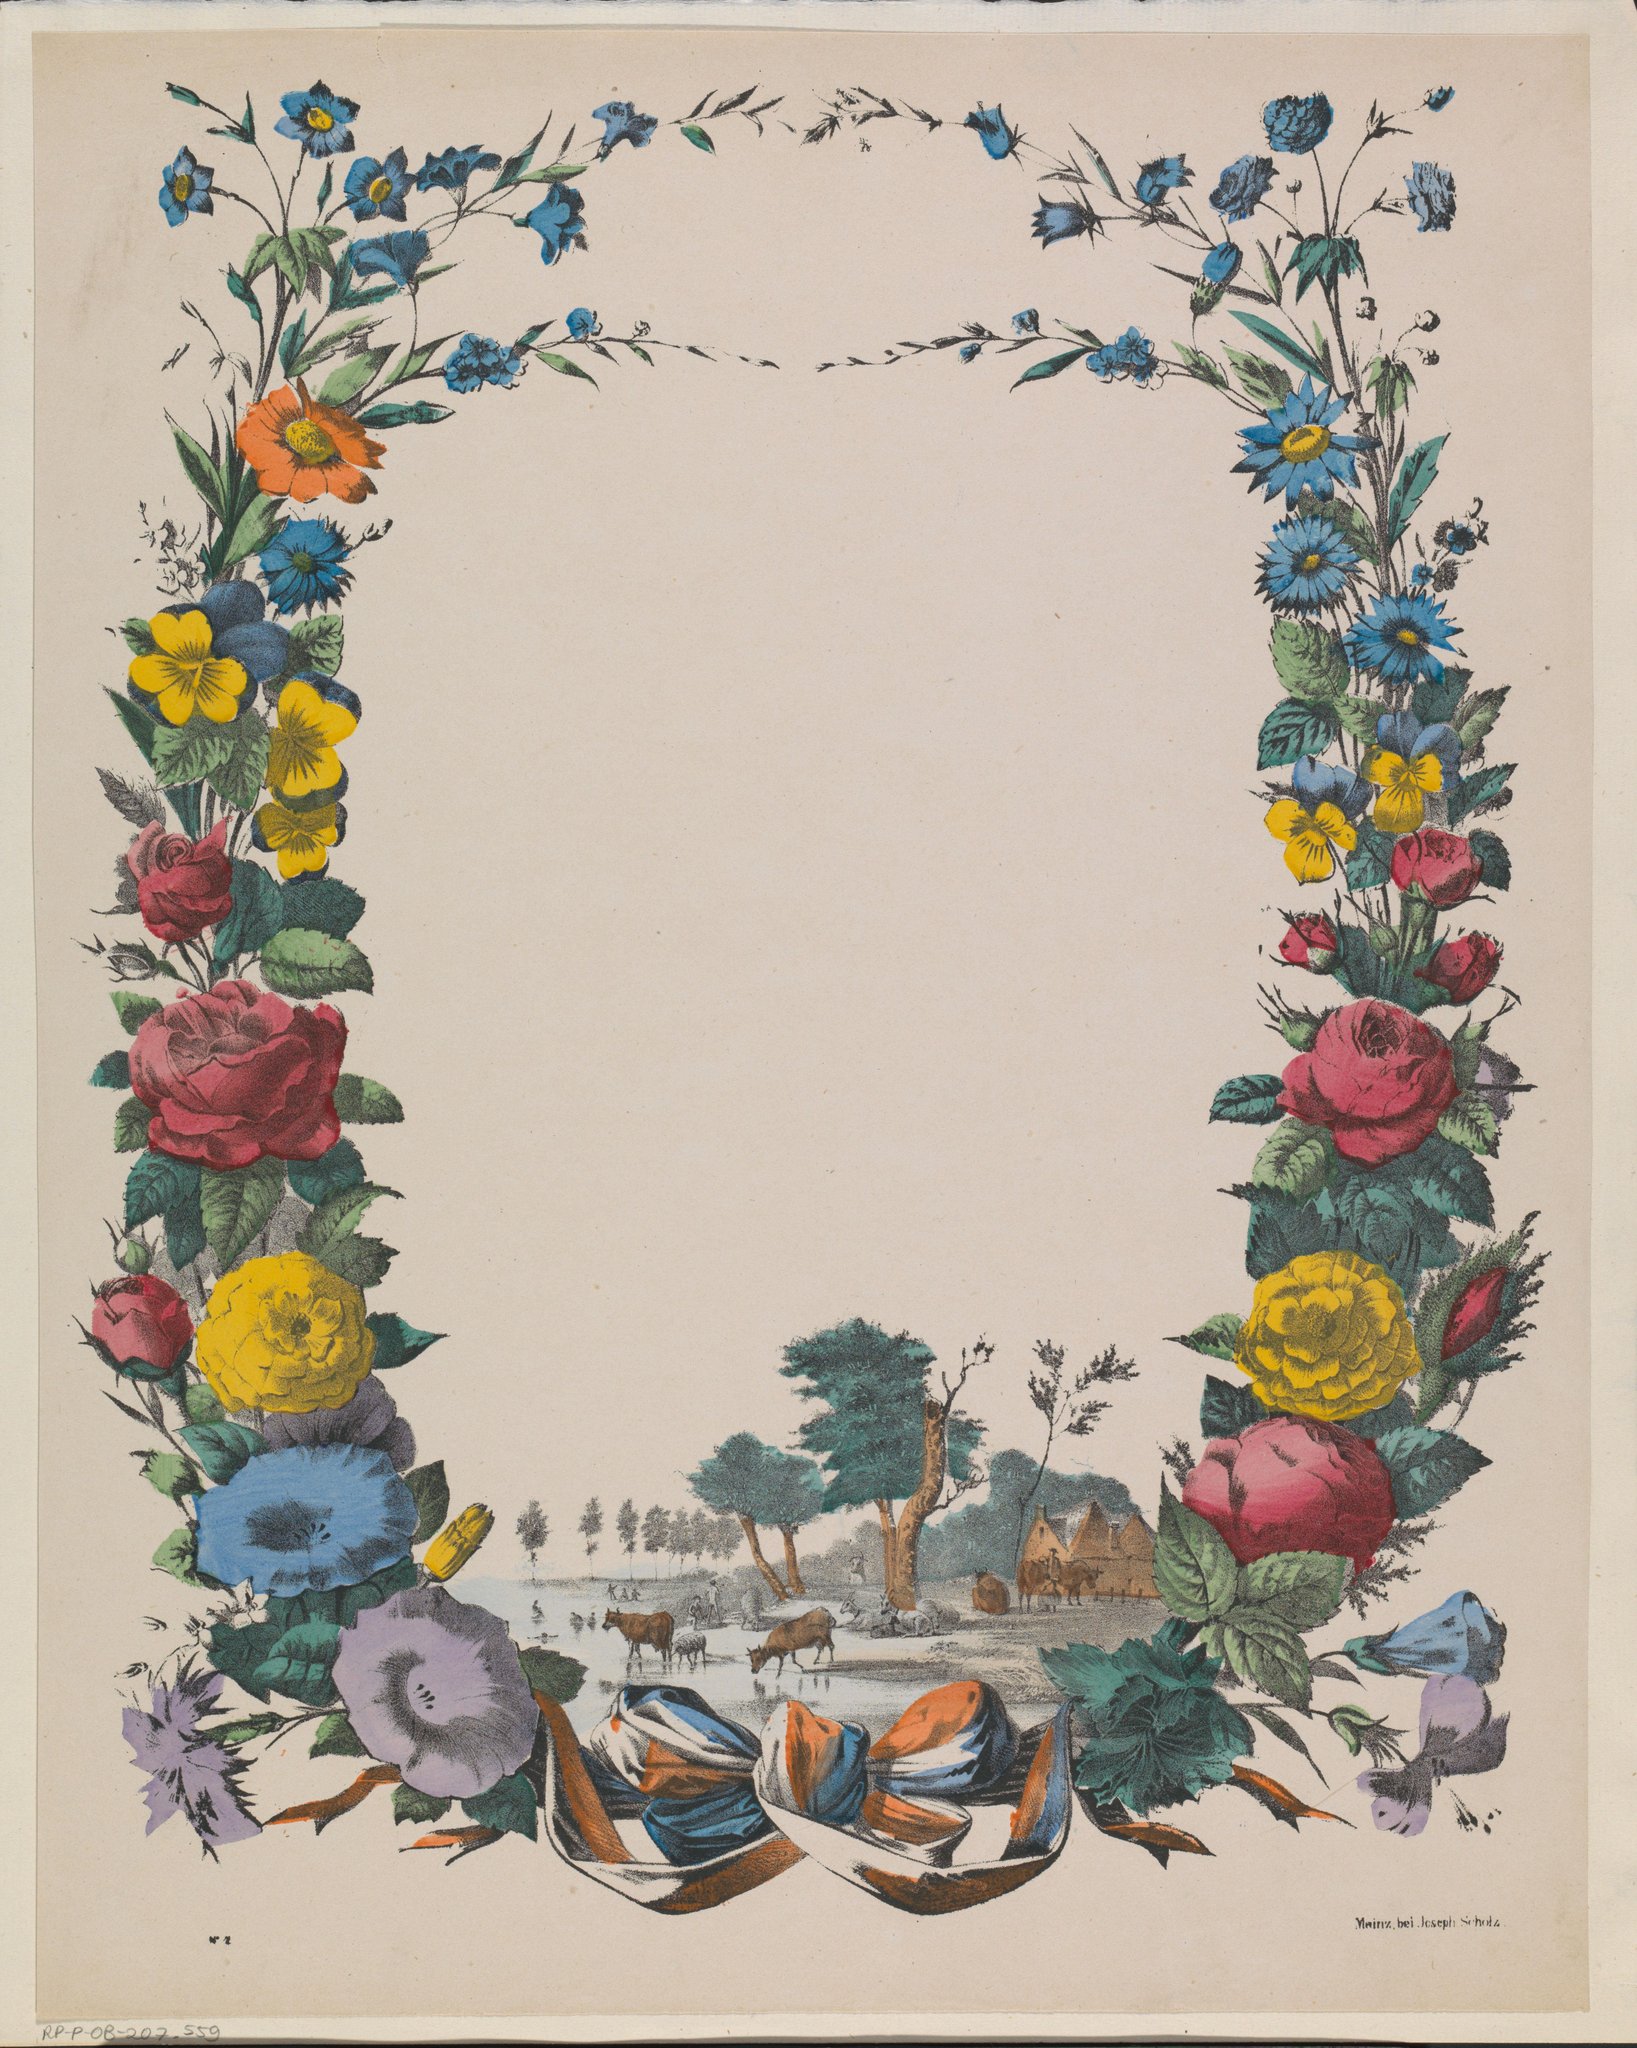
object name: popular print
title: Wensbrief met bloemenkrans en landschap met boerderij en dieren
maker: Anonymous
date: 1829-1880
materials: paper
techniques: colour, lithograph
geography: mainz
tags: flowers, animals, farm (building)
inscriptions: collector's mark: Lugt 2760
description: Wensbrief met onbeschreven cartouche binnen een decoratief kader met voorstellingen van een bloemenkrans en een landschap met een boerderij en dieren. Genummerd linksonder: No. 2.